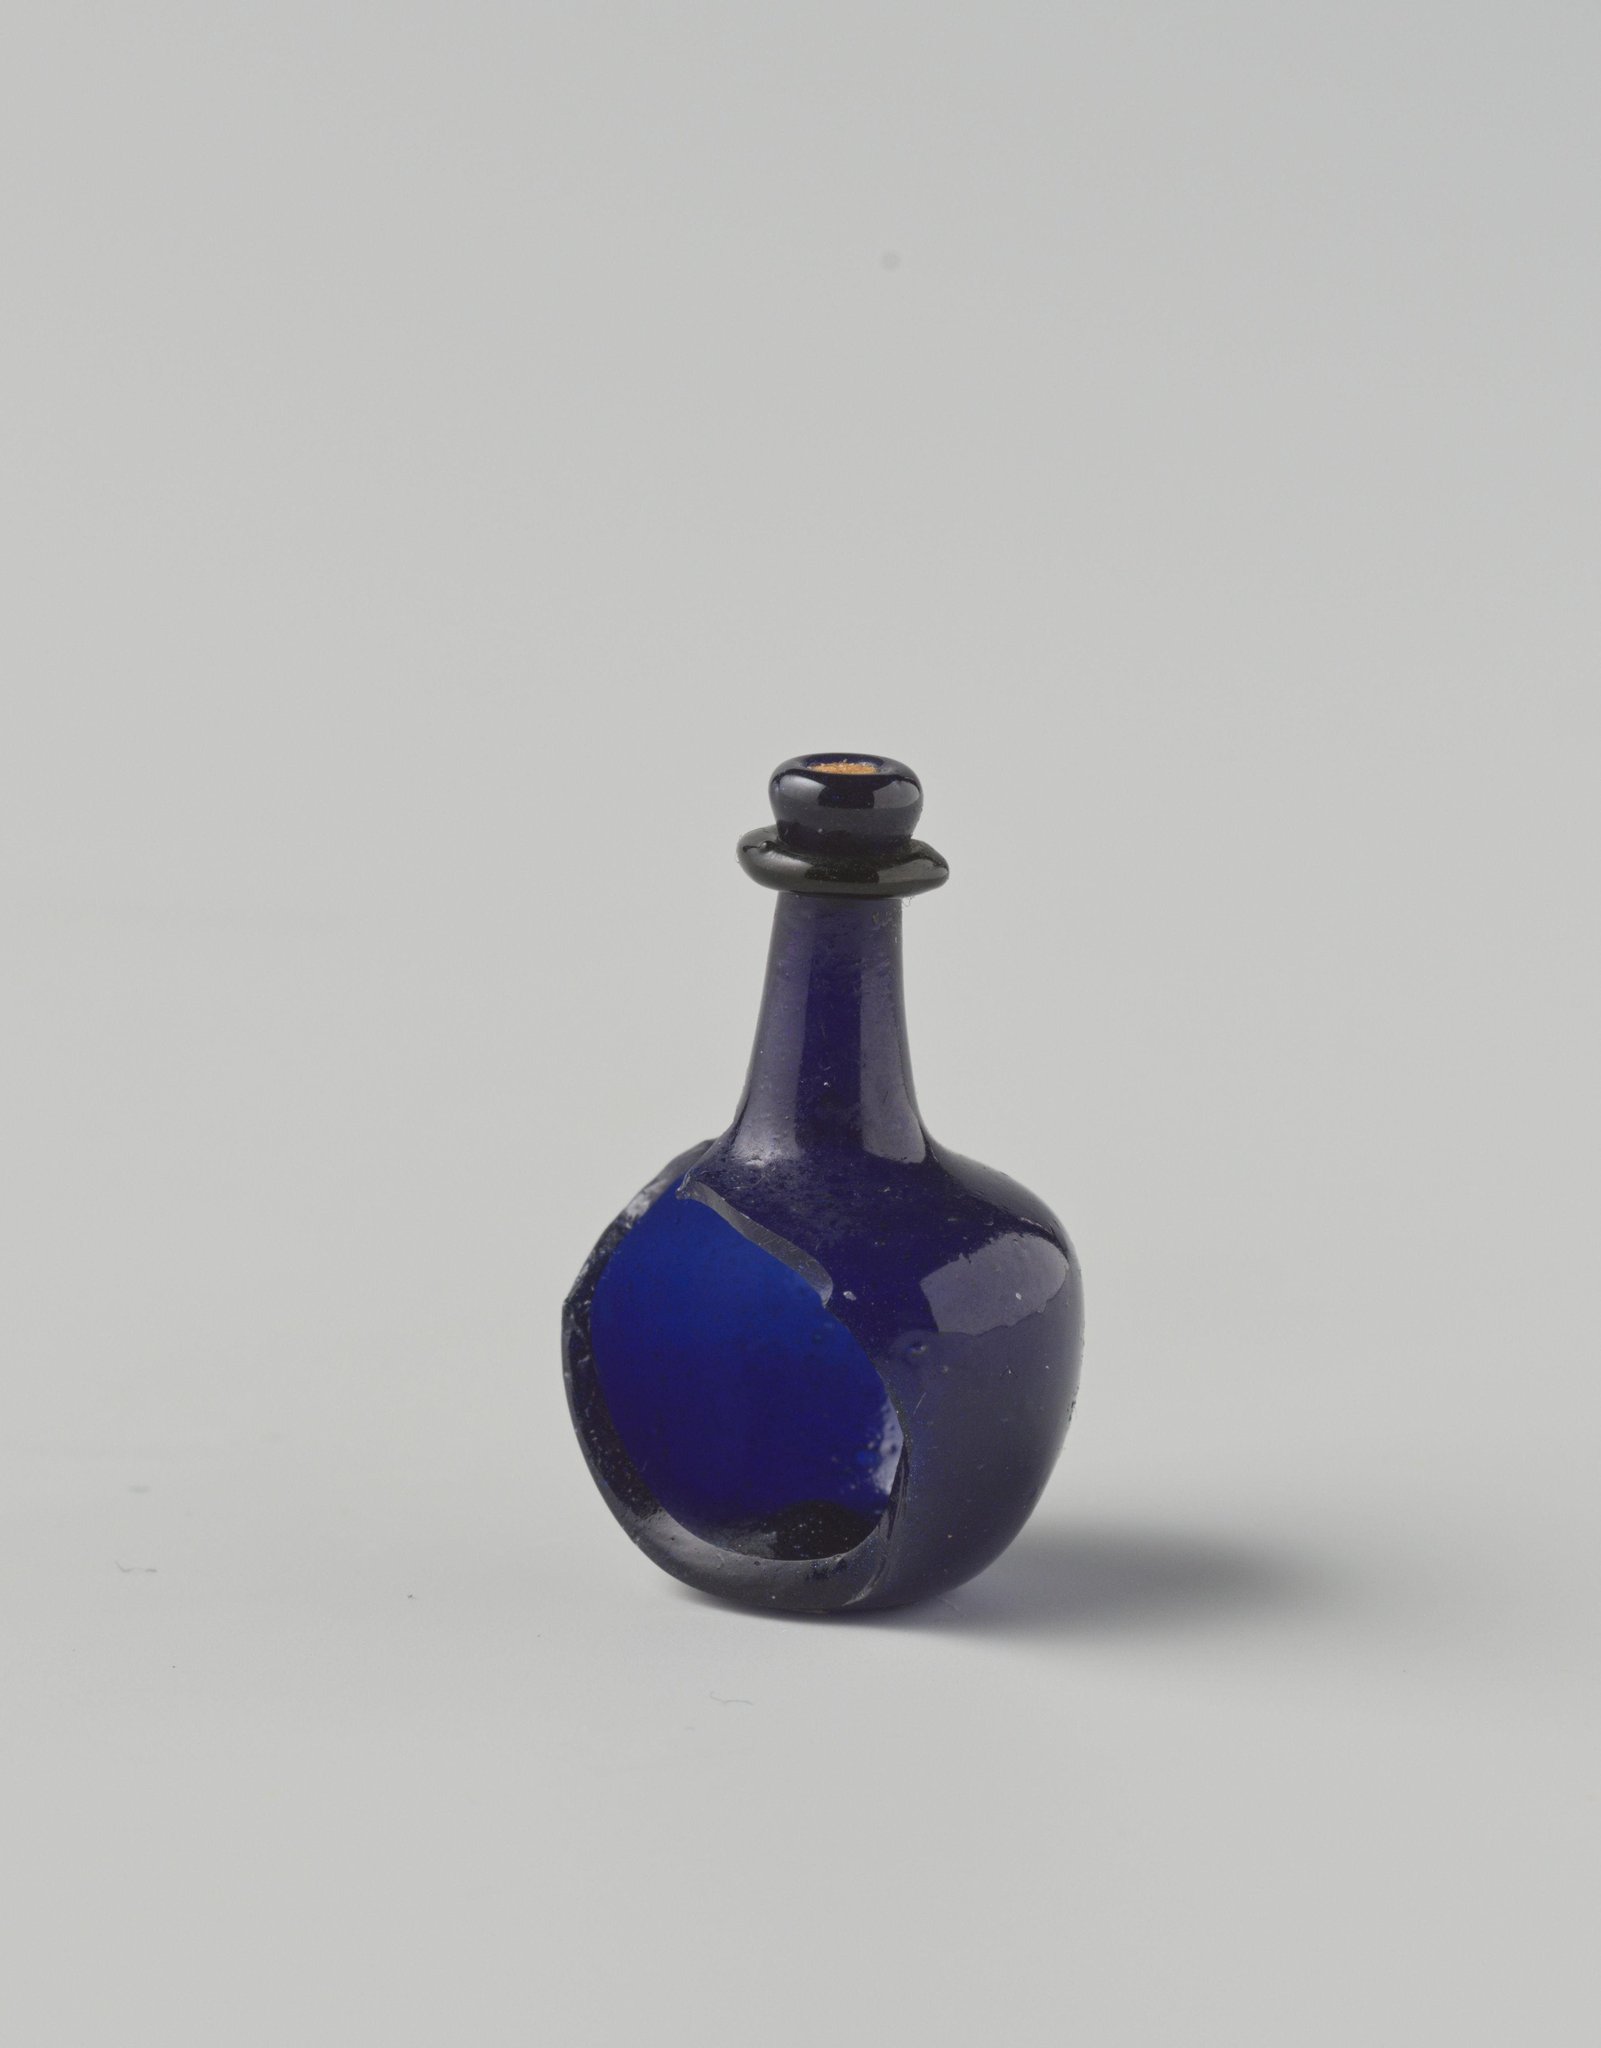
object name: bottle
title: Fles van helder, diep blauw glas; buik met weinig ingestoken ziel, hoge hals met druipring (deel buik ontbreekt). Kurk in de hals opening.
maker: Anonymous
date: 1675-1710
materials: cork, glass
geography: amsterdam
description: Fles van helder, diep blauw glas; buik met weinig ingestoken ziel, hoge hals met druipring. (Deel buik ontbreekt). Kurk in de halsopening.